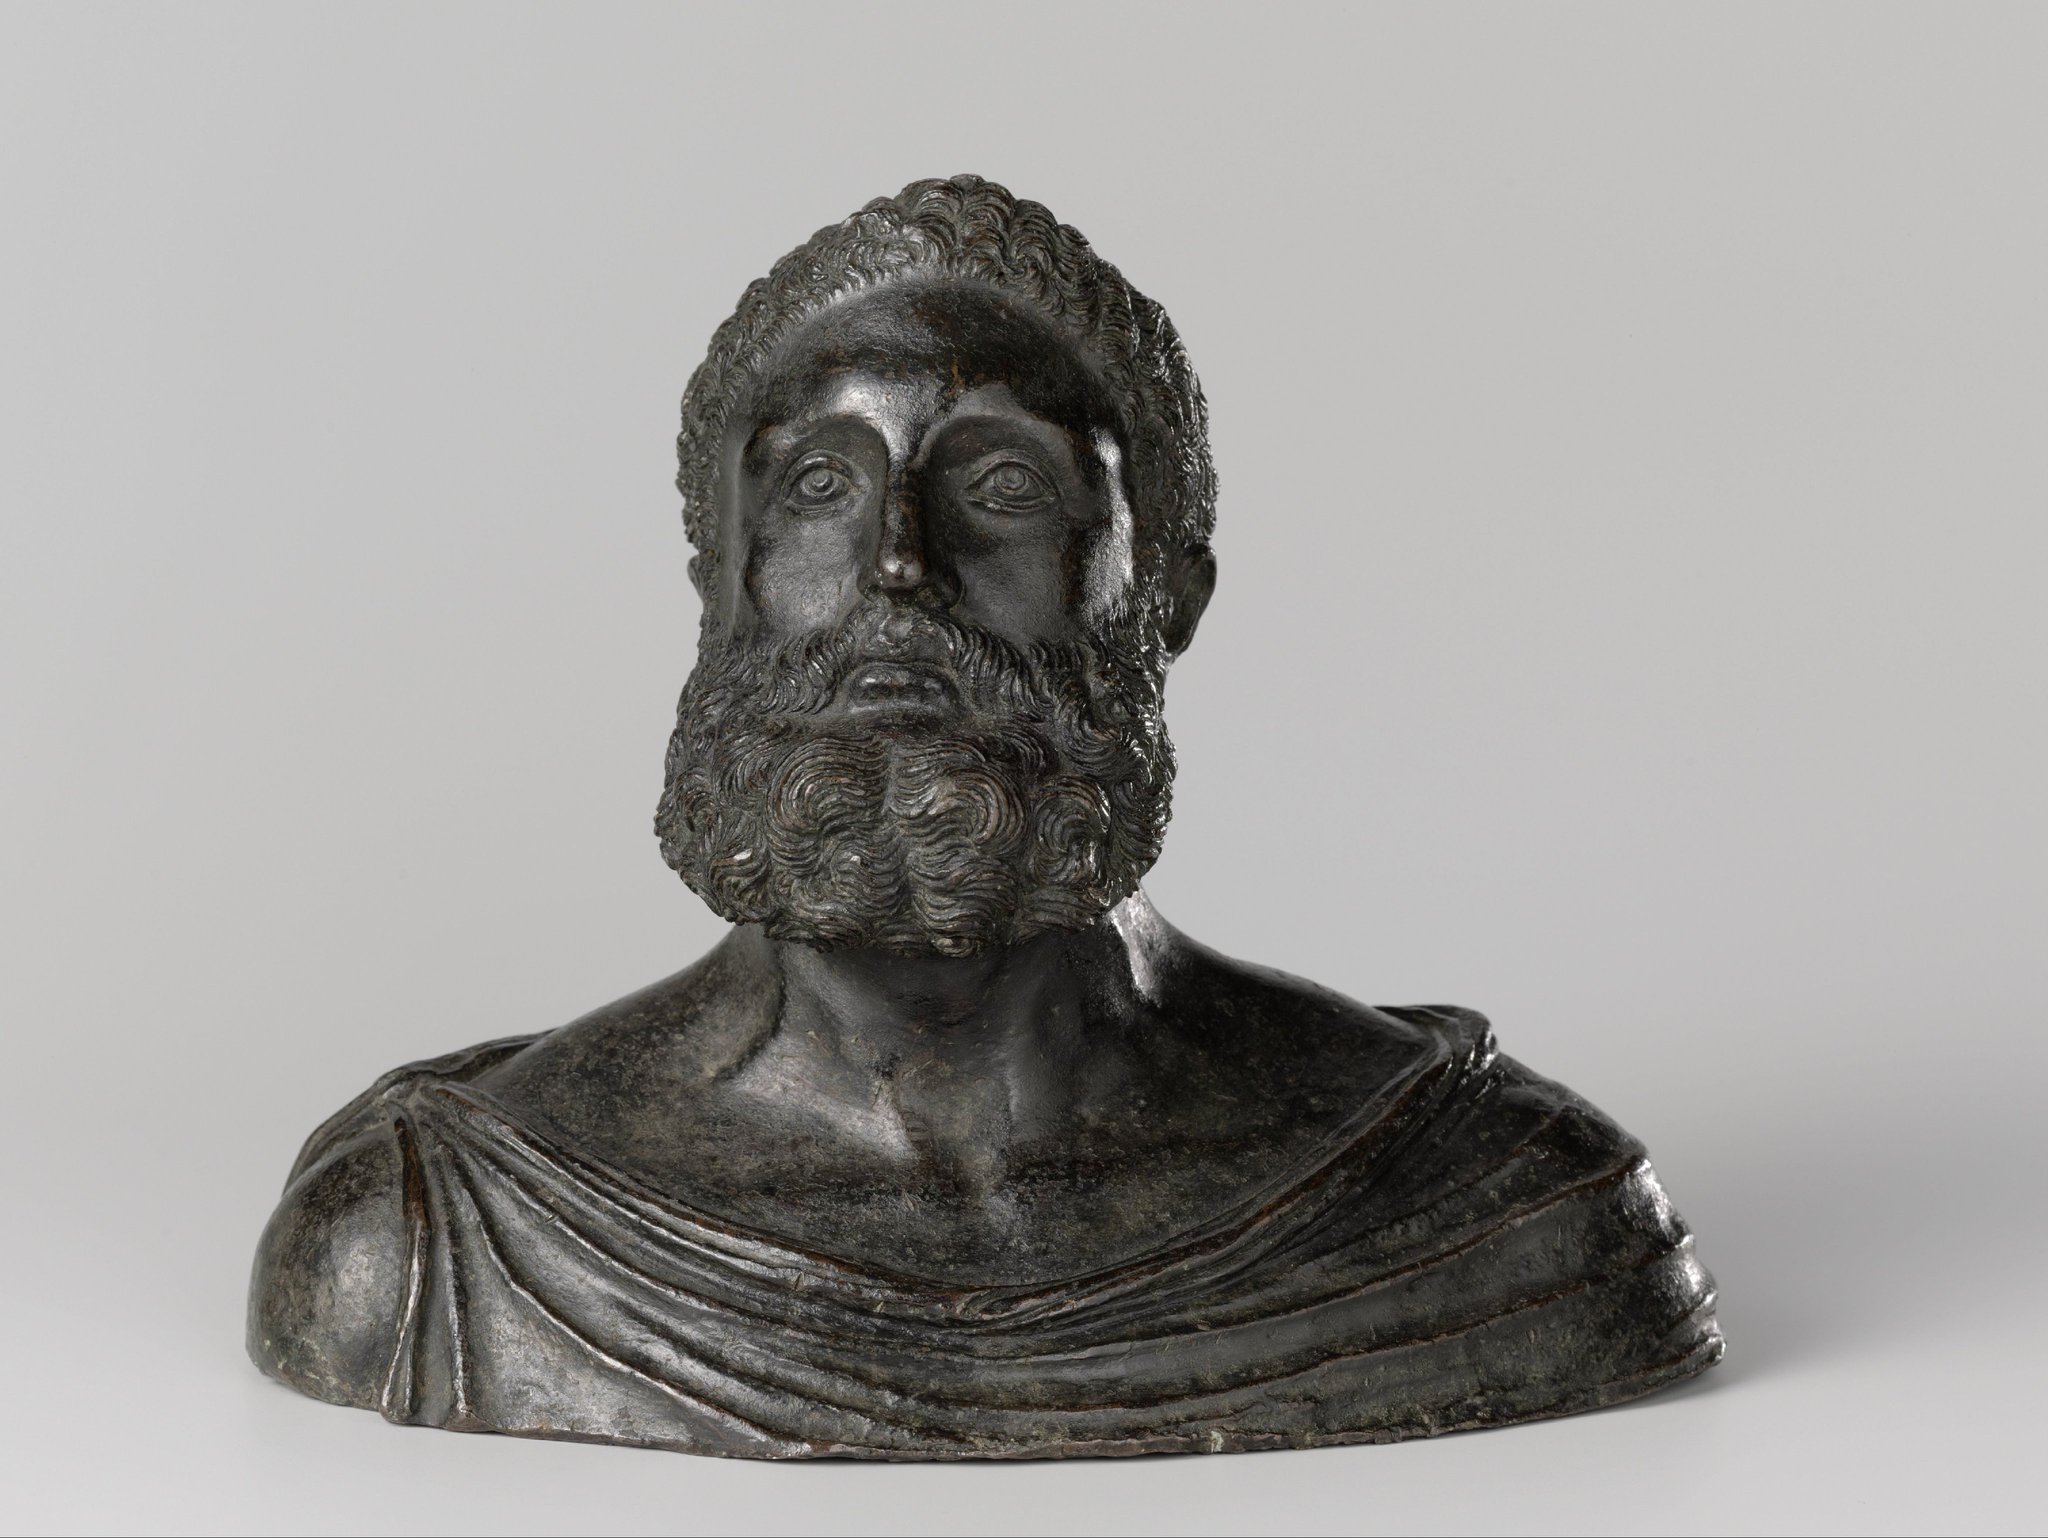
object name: figure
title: Bust of a Classical philosopher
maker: antonio lombardo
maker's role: sculptor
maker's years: 1458-1516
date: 1505-1525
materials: bronze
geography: padua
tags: beard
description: De man houdt het opgeheven hoofd iets naar links, draagt snor en baard en om het krullende haar een band. Over de schouders hangt een klassieke toga, waarvan de twee einden op de rechterschouder door een knoop worden samengehouden.